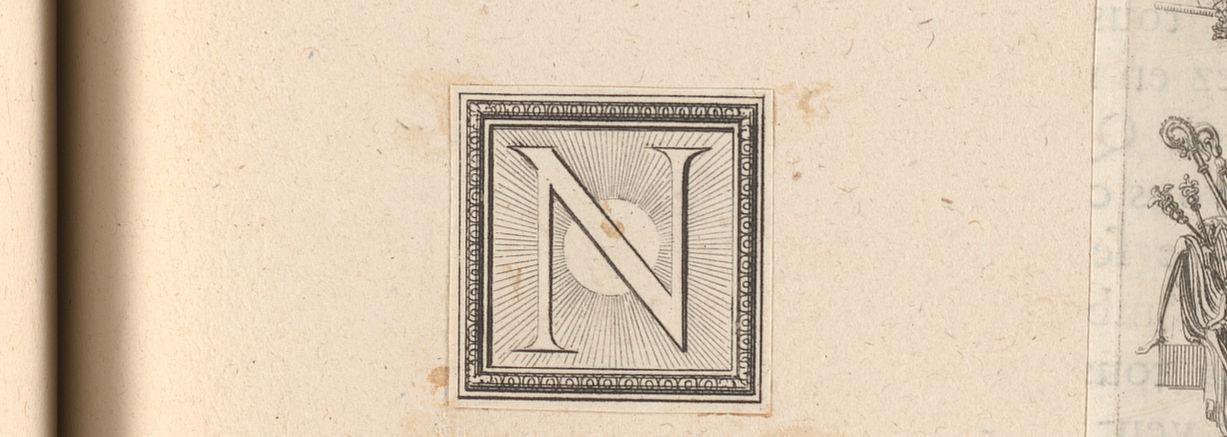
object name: print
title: Initiaal 'N' met een stralende zon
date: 1697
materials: paper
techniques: etching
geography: paris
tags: initial, sun as celestial body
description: Initiaal gebruikt voor: Genest, Abbé Charles-Claude. L'Histoire, à Madame la duchesse de Bourgogne (...). Parijs: Jean Anisson, 1697.